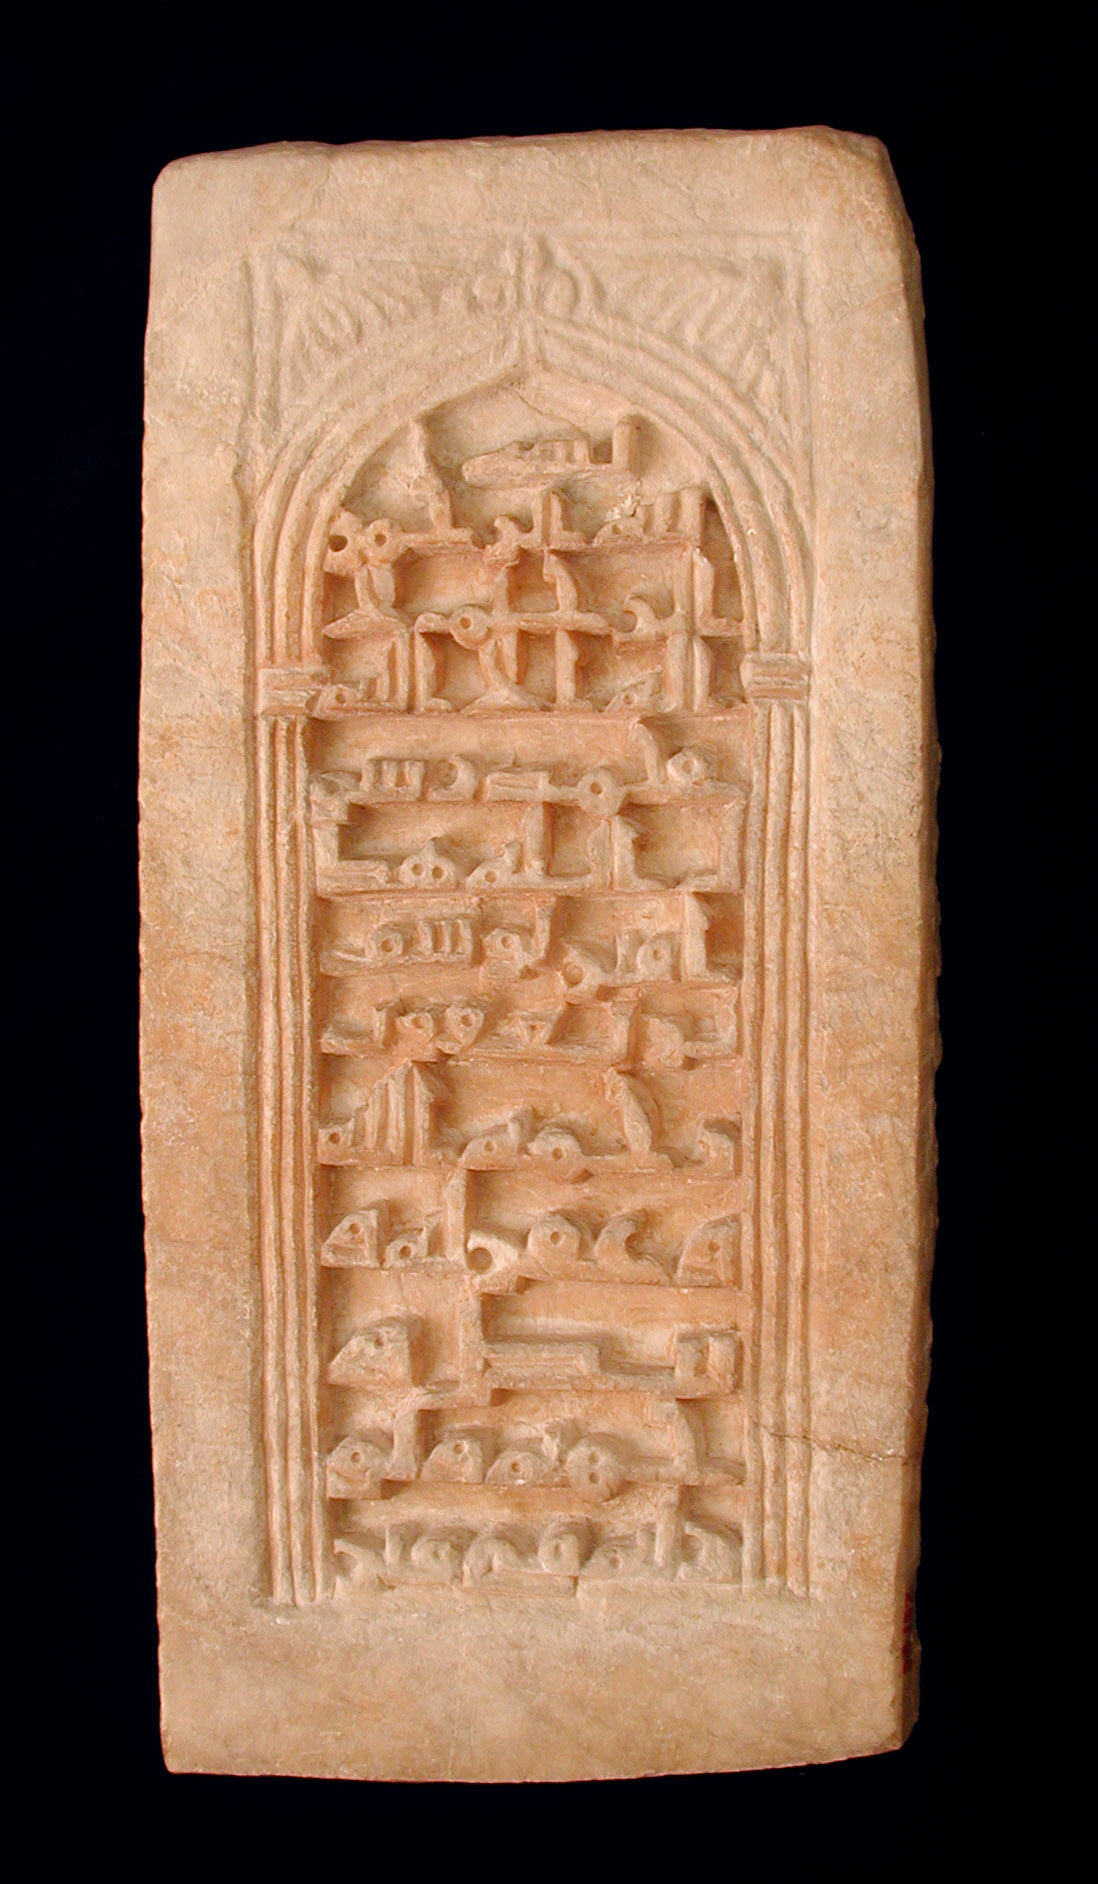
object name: gravestone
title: Gravestone of Yusuf ibn Yaqub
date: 901-1000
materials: alabaster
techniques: carving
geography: iran